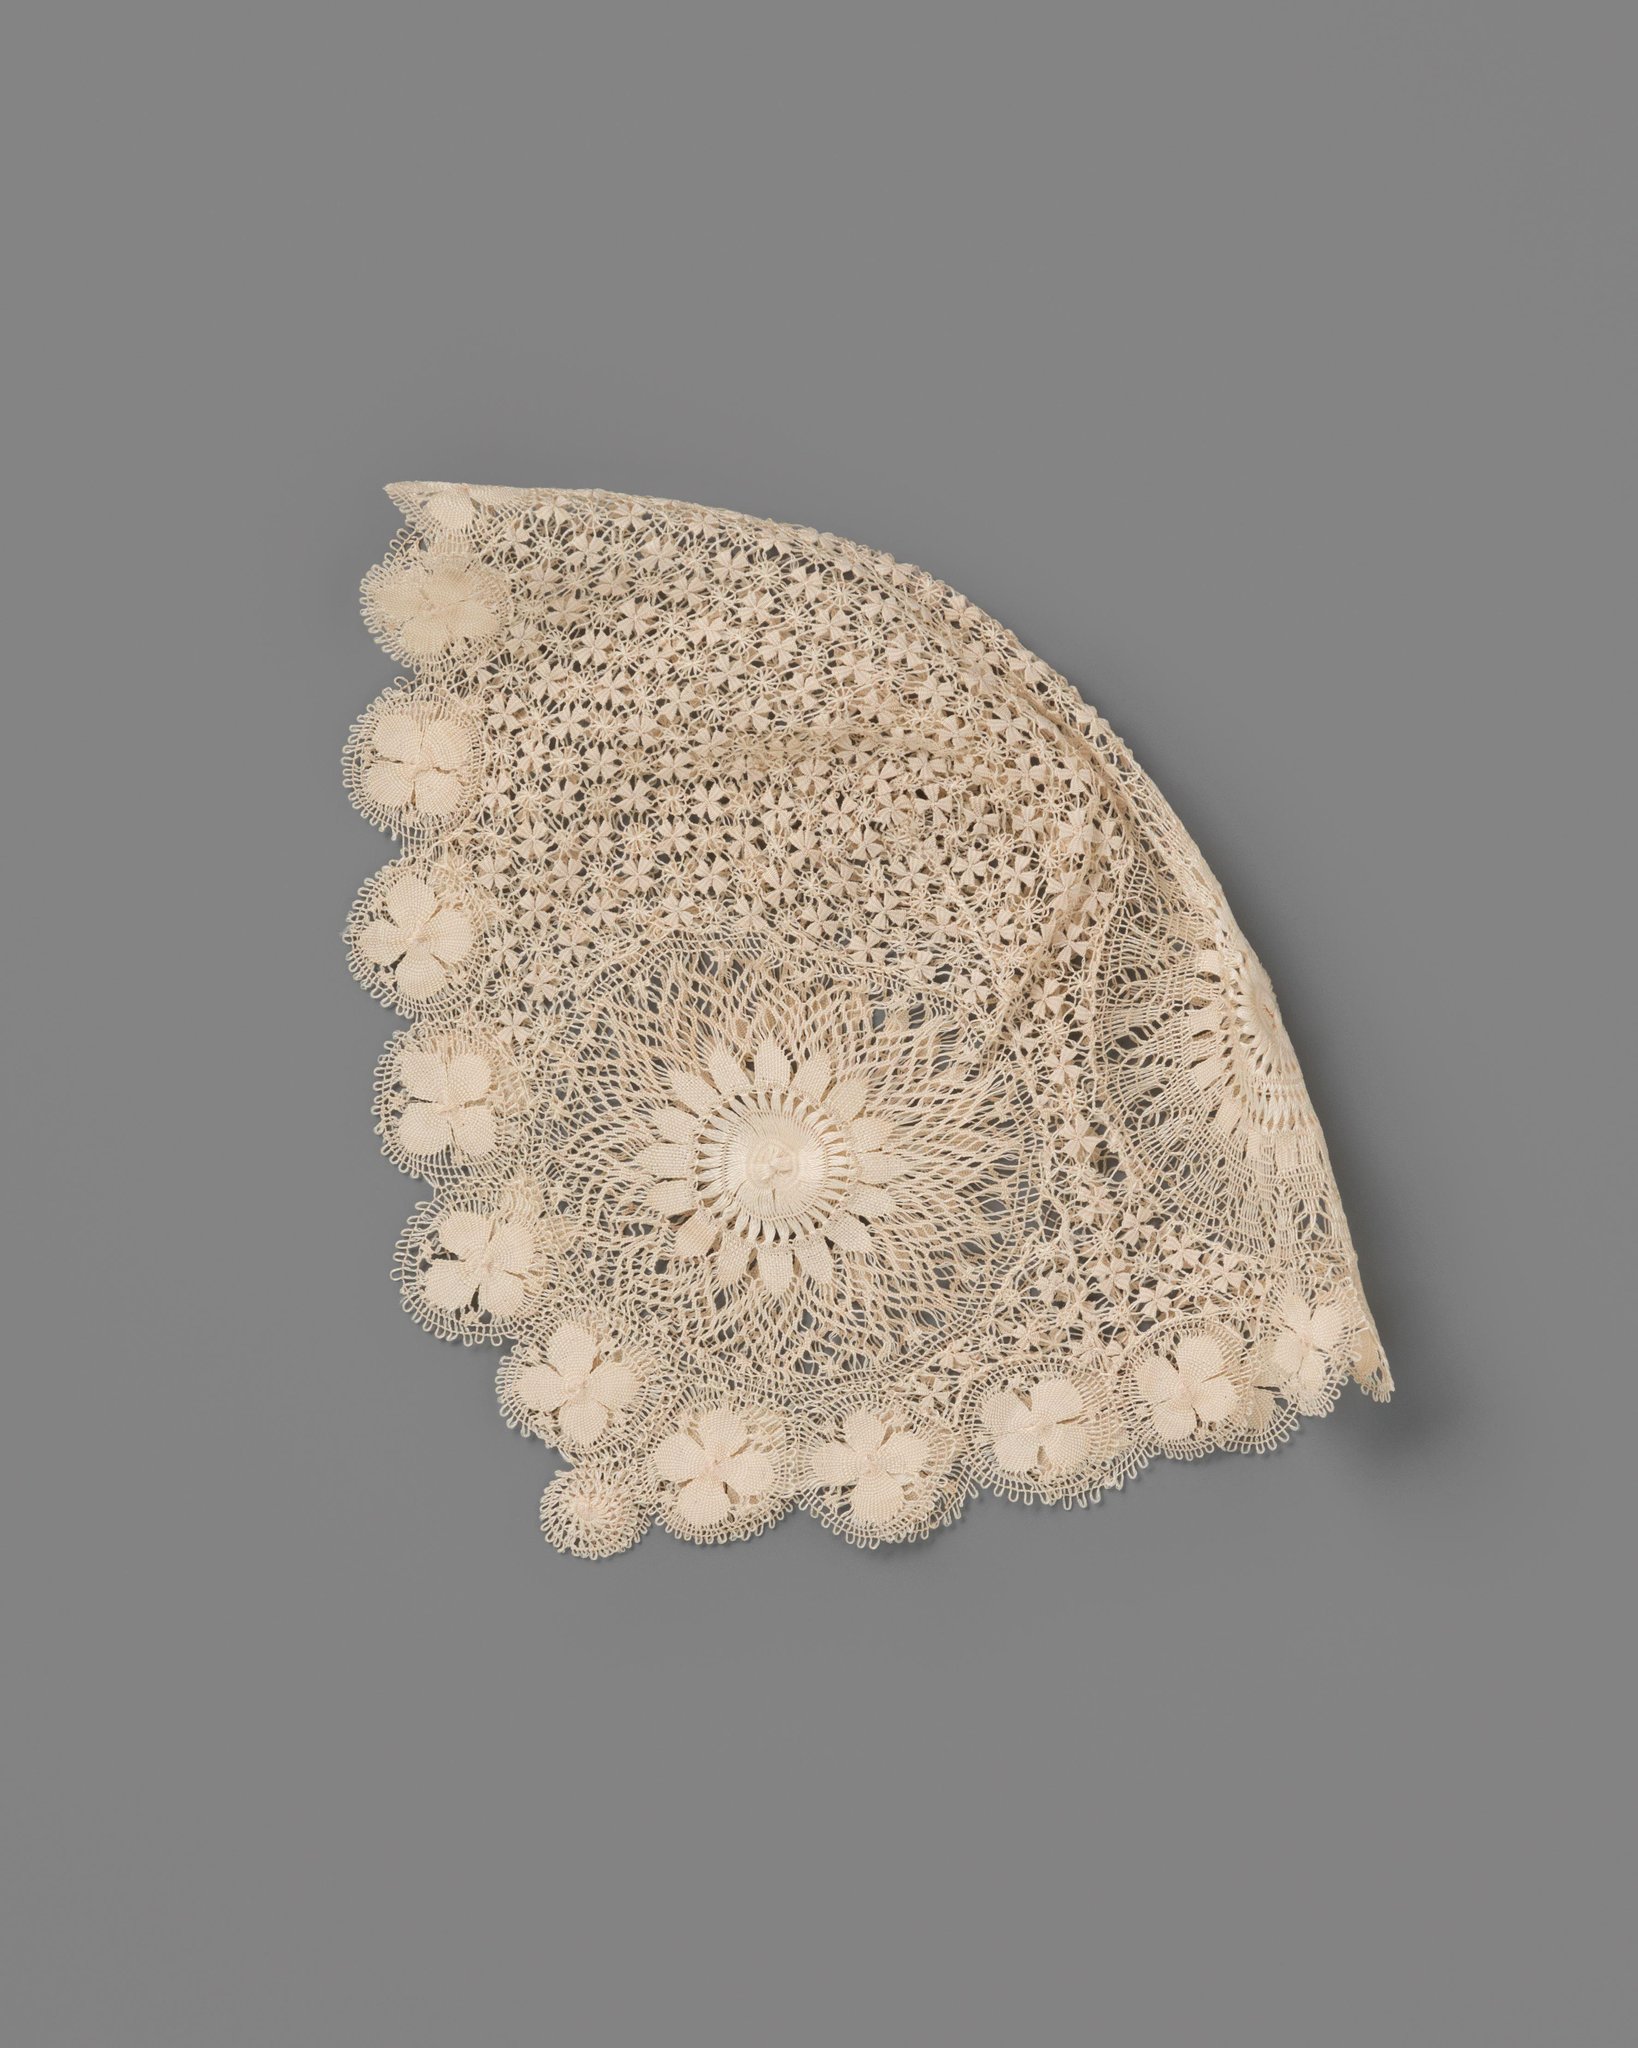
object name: cap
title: Muts van crèmekleurige zijden naaldkant, Tenerife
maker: Anonymous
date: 1912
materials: silk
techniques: lace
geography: paraguay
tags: de bosch kemper, paraguay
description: Muts van cremekleurige zijden naaldkant Tenerife. Geschulpte rand met patroon van cirkels met vierbladige bloemen. Langs de onderrand drie grote cirkels waarin steeds een ander motief. Grond van servetwerk met eveneens bloemen en cirkels. Bij deze muts hoort een satijnen ondermuts (BK-1994-15).